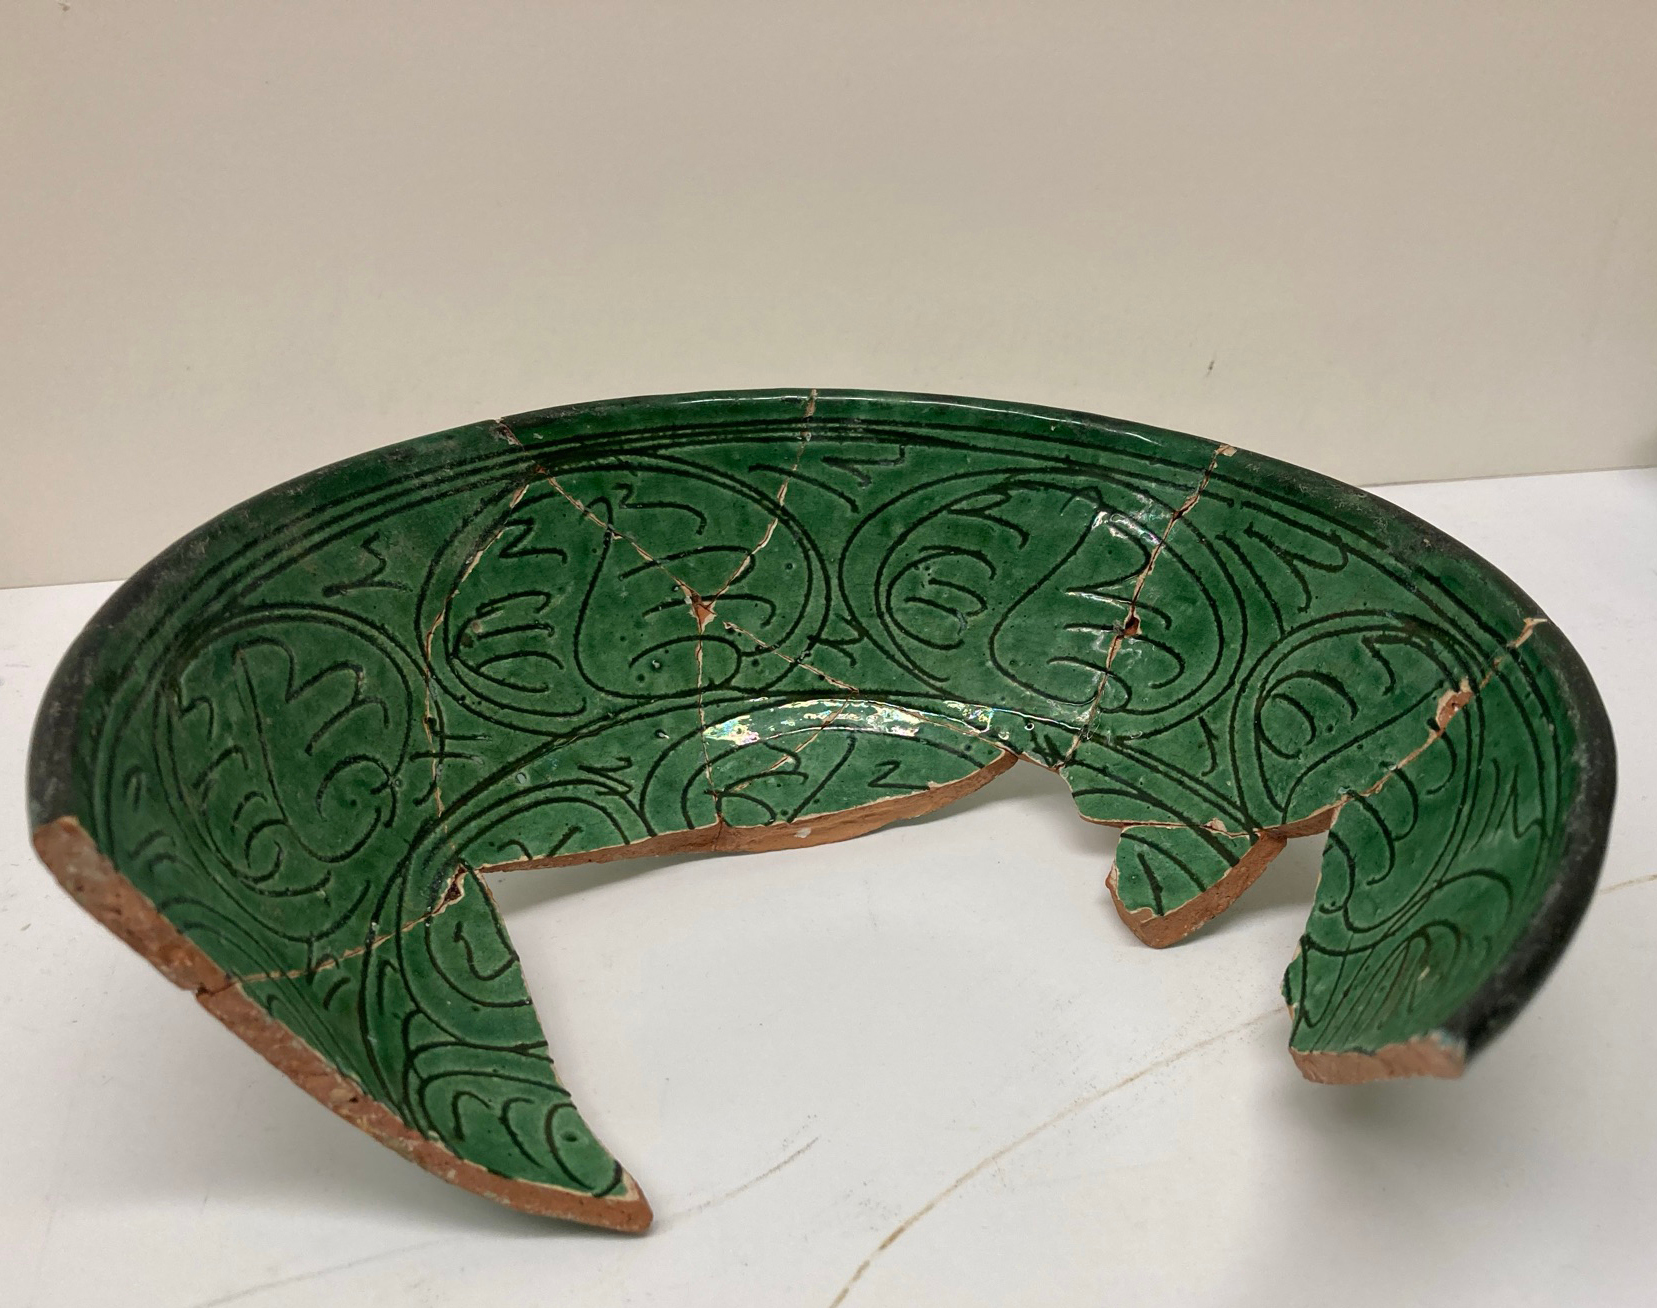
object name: bowl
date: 801-900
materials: earthenware, glaze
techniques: incising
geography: iran